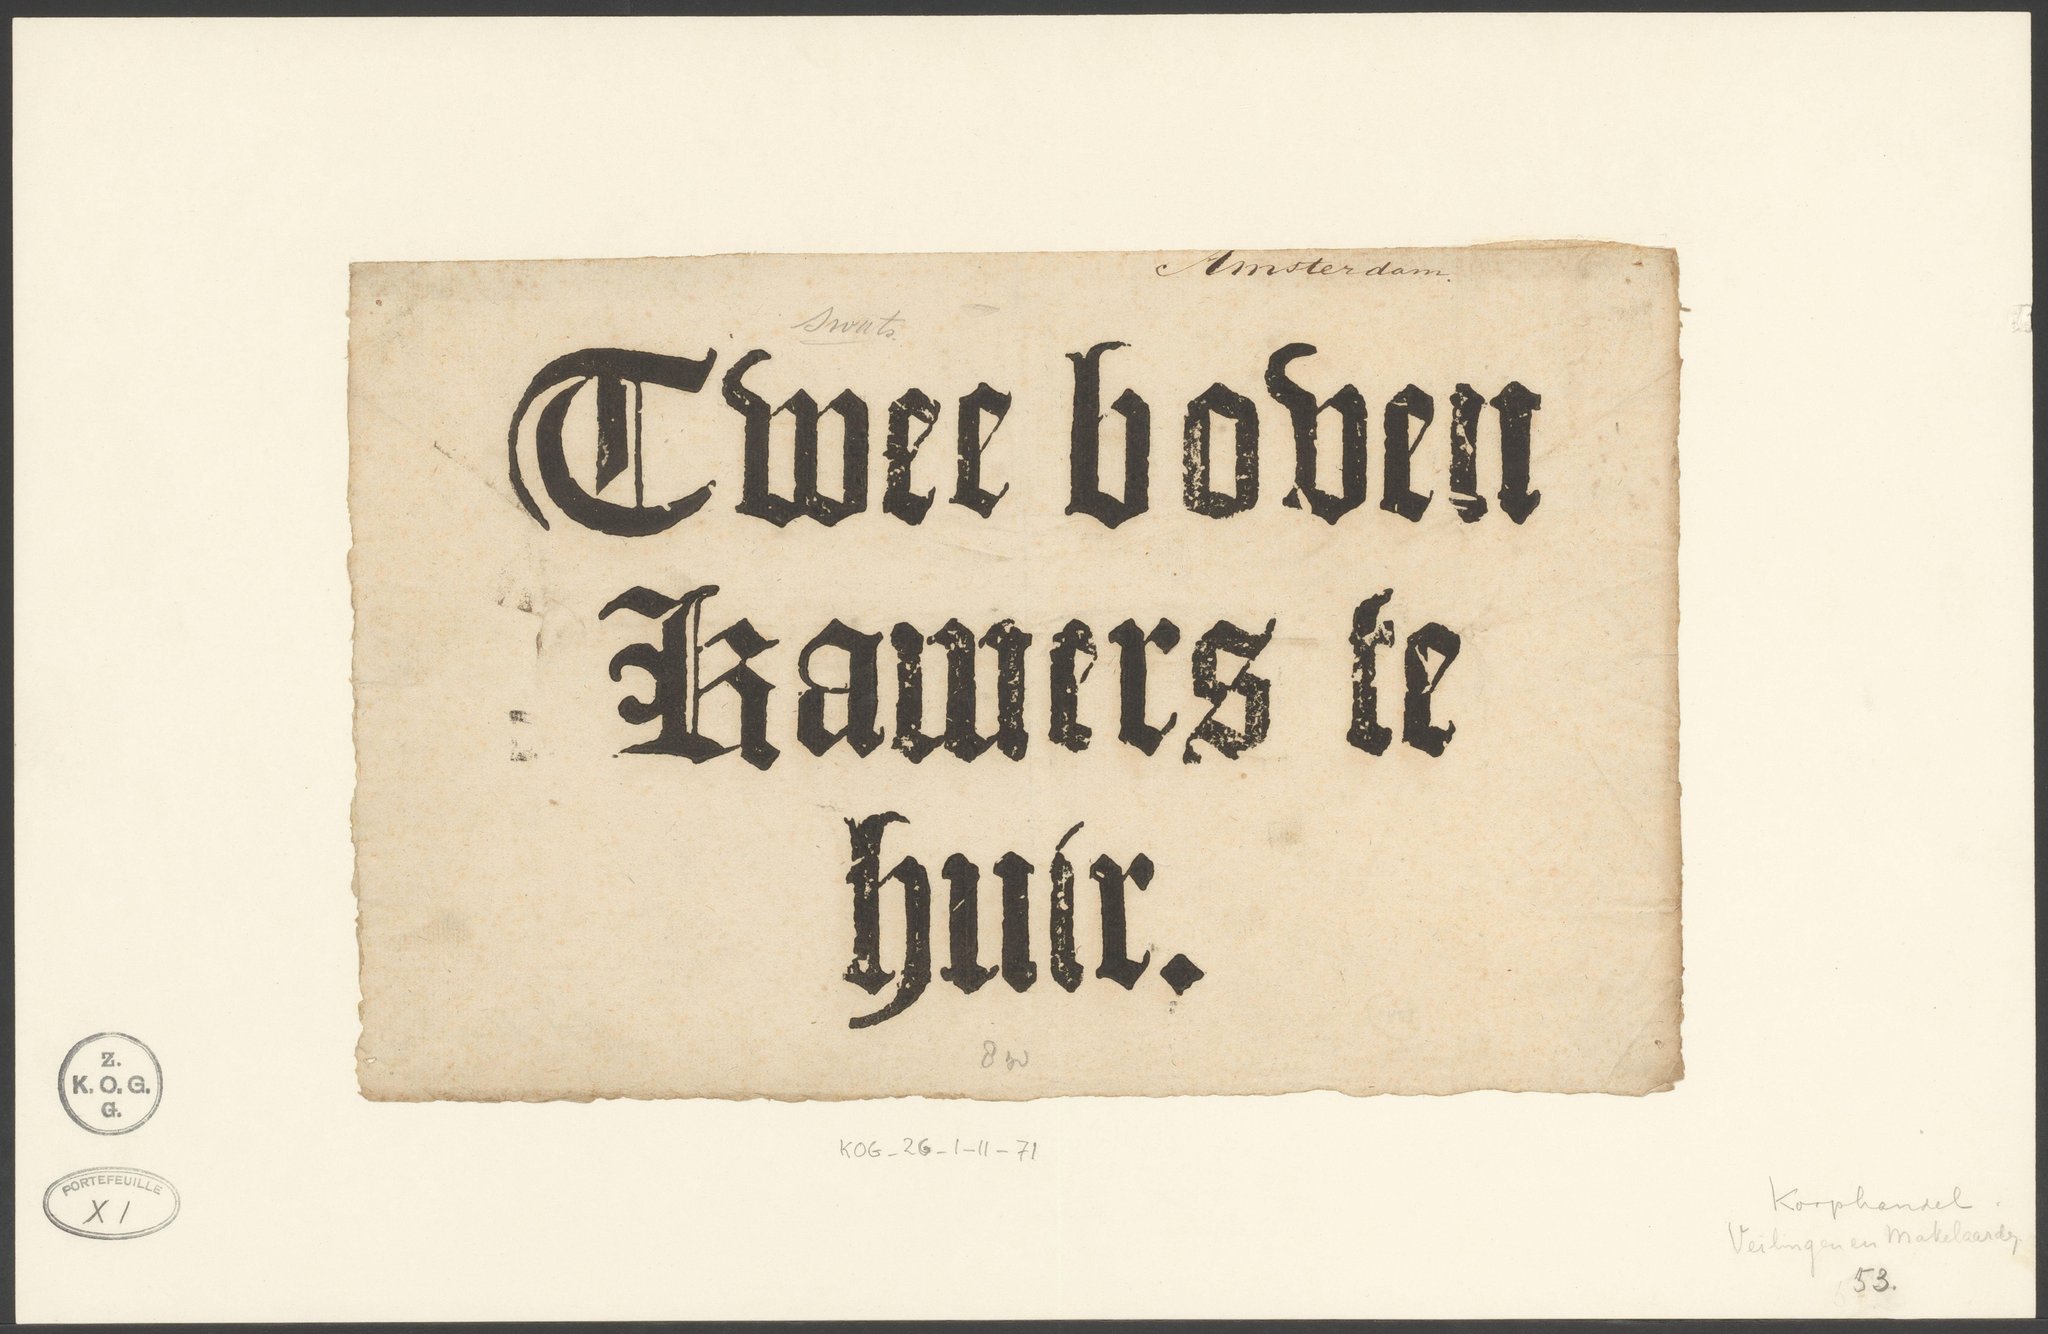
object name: text sheet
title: Twee boven kamers te huir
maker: Anonymous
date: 1600-1799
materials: paper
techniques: letterpress printing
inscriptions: stamp, collector's mark: Lugt 1641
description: Onderwerpsrubrieken binnen de Atlas Zeden en Gewoonten: Handel, nijverheid en verkeer, Koophandel, Veilingen, Makelaardij en Verzekeringswezen. Kamers te huur.